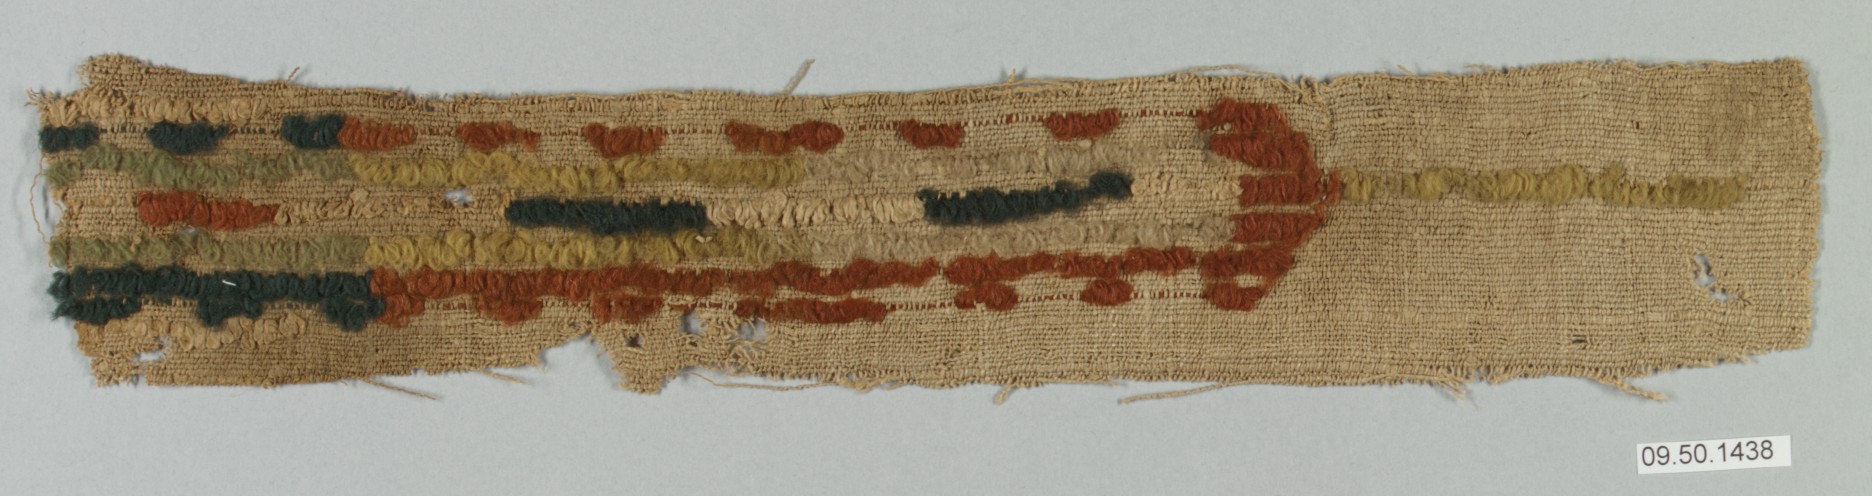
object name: textile fragment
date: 301-500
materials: linen, wool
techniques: embroidery, weave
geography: egypt